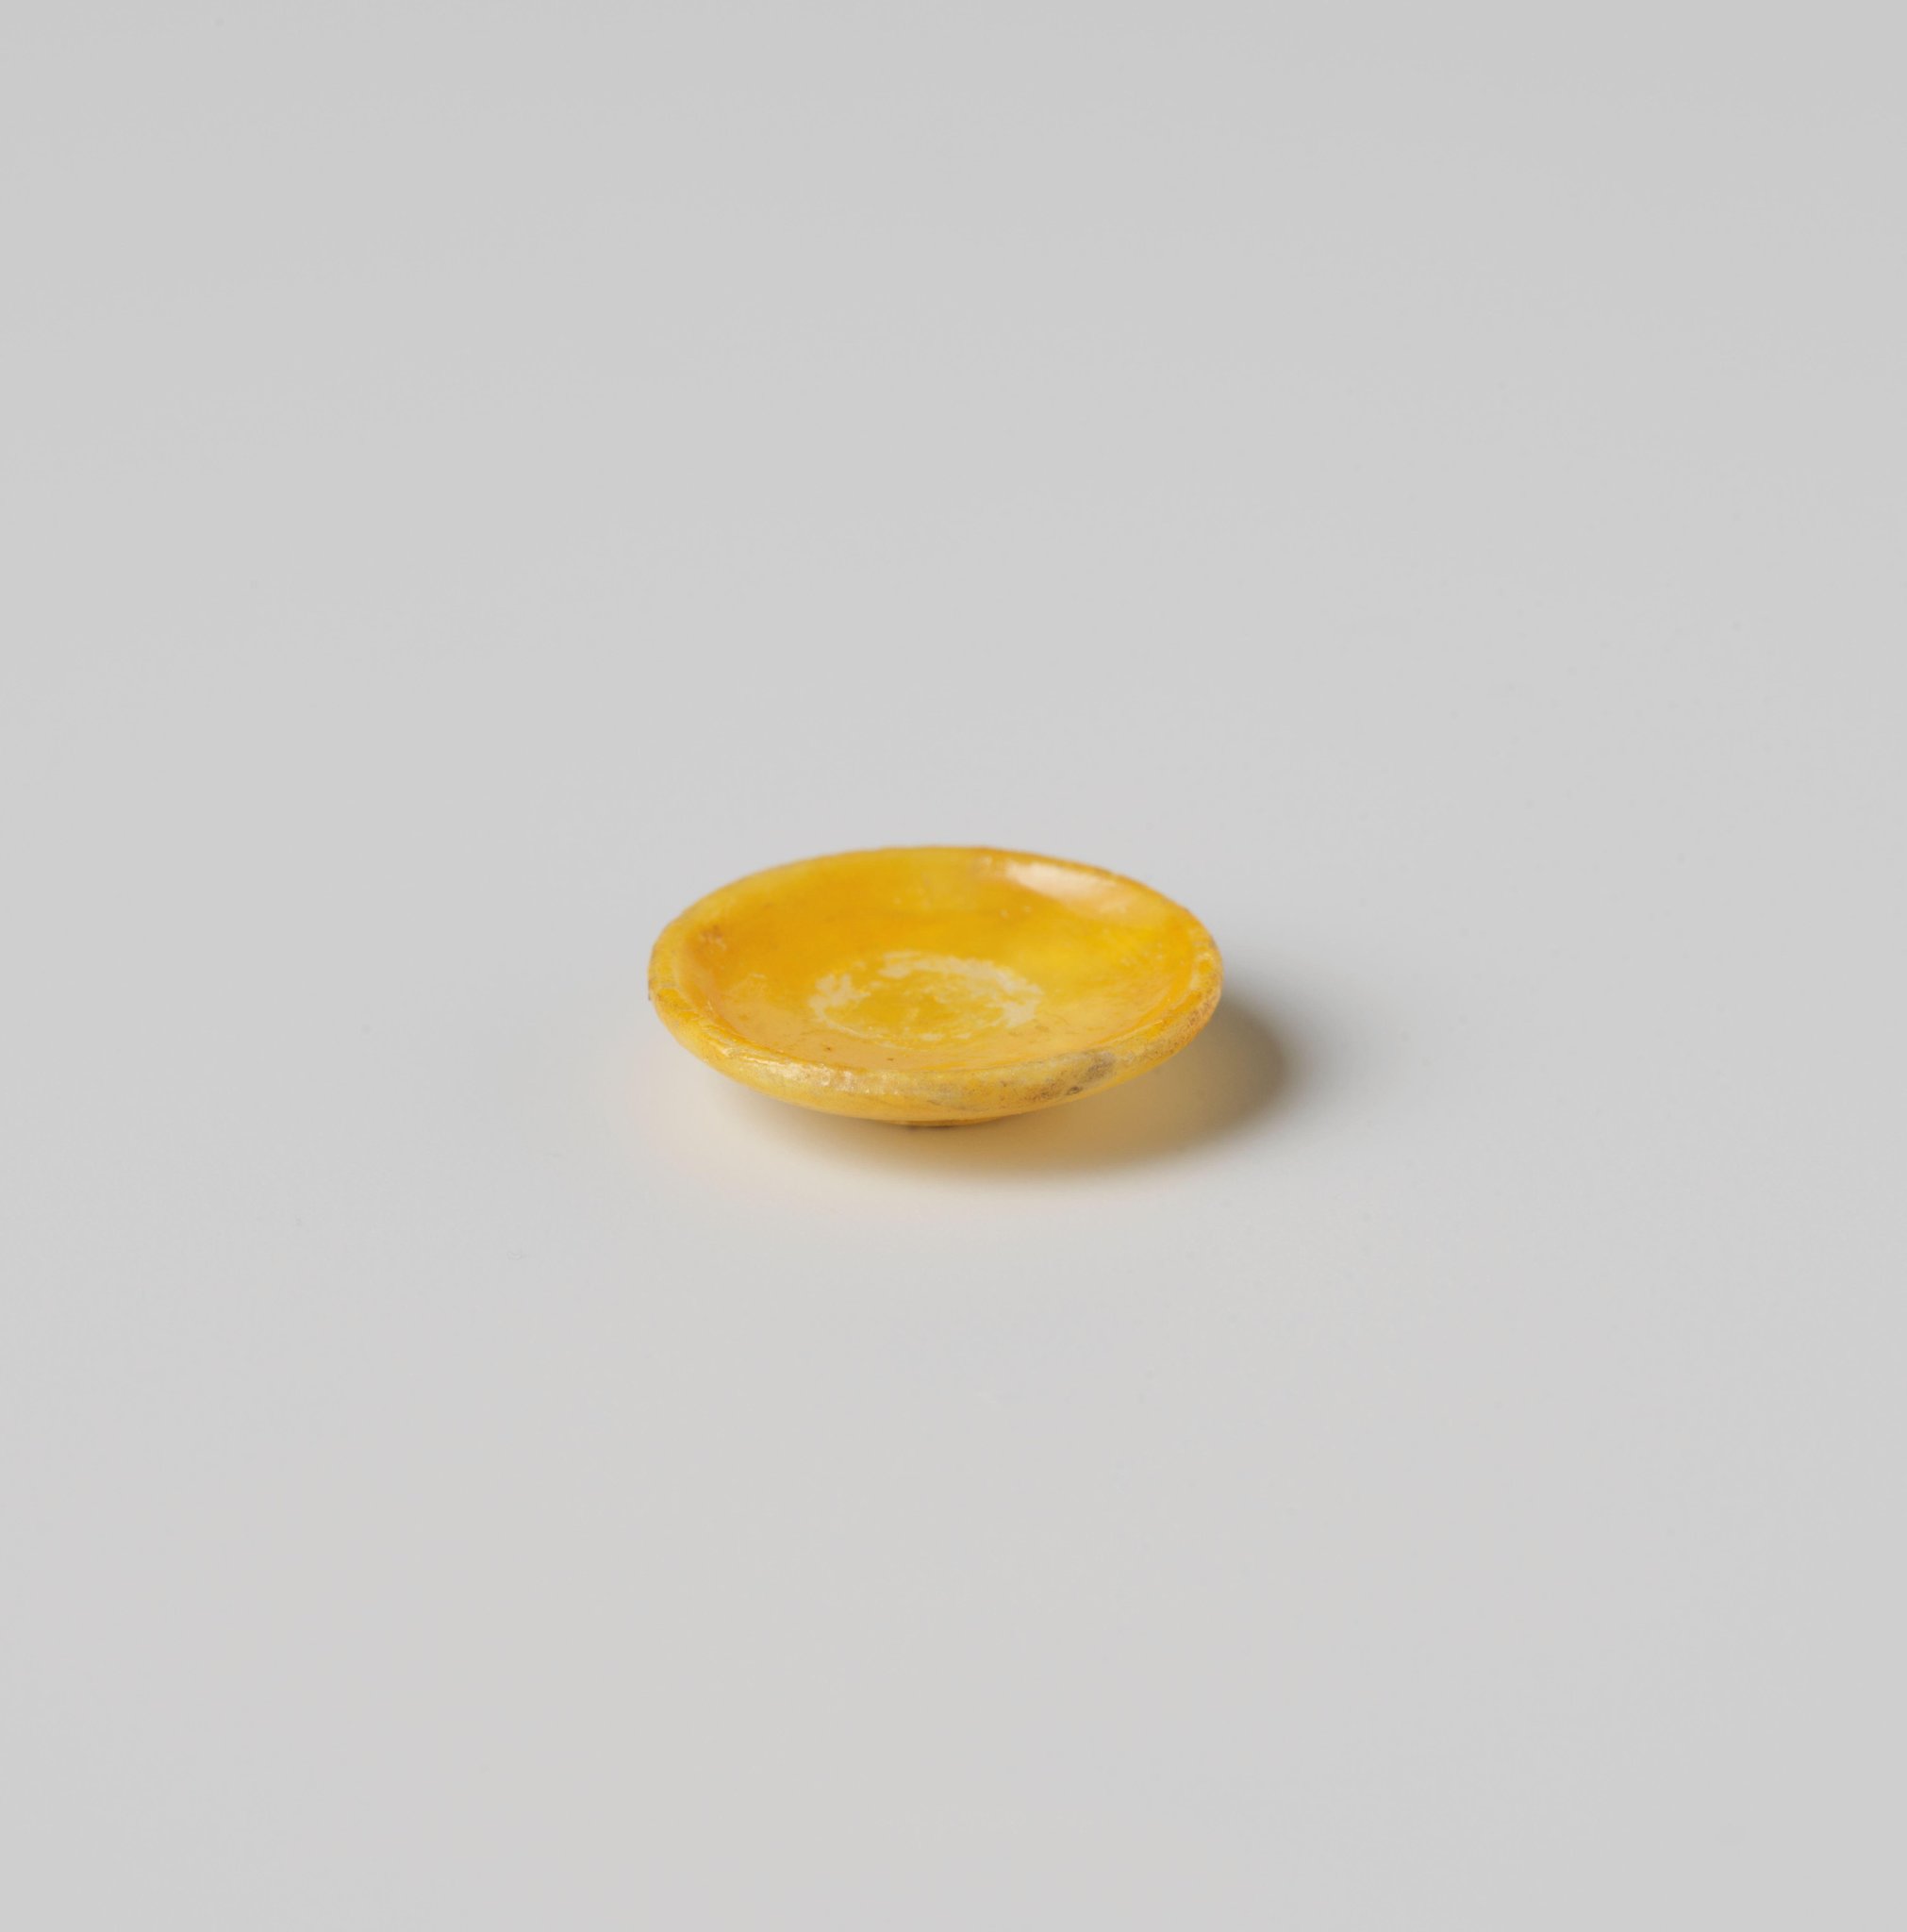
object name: platter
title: Schotel, geelgelakt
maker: Anonymous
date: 1750-1800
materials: alabaster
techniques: lacquer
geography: germany